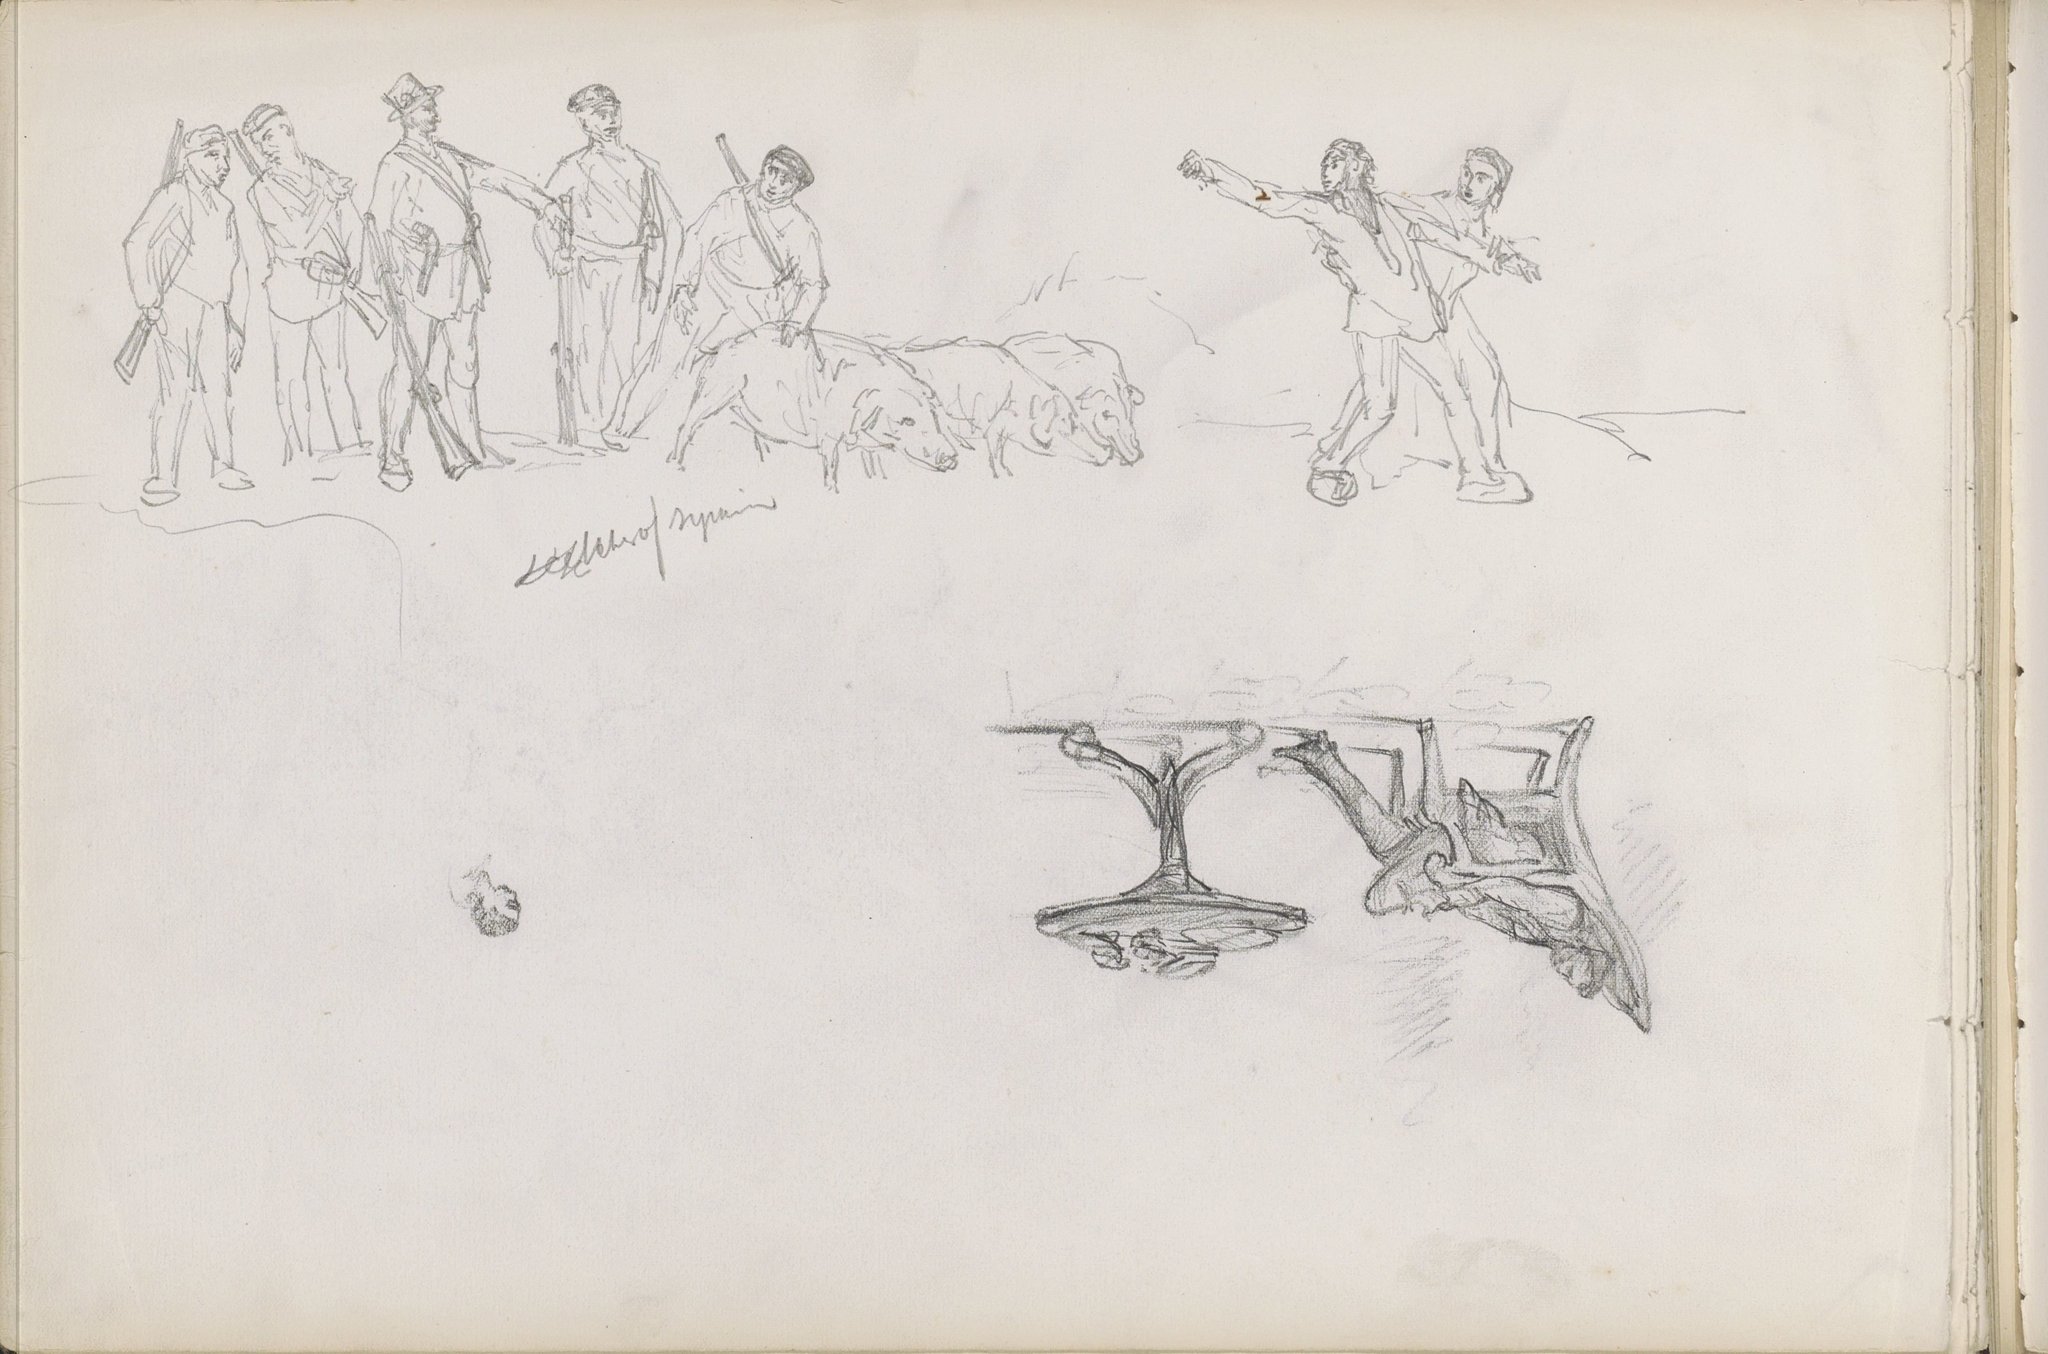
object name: sketchbook leaf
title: Zittende man en soldaten met varkens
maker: george hendrik breitner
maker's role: draughtsman, painter, print maker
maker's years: 1857-1923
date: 1873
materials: paper, pencil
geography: rotterdam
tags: pig, table, division of armed forces, sitting on an elevation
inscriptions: annotation: ‘[...]’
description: Blad 29 verso uit een schetsboek met 25 bladen.